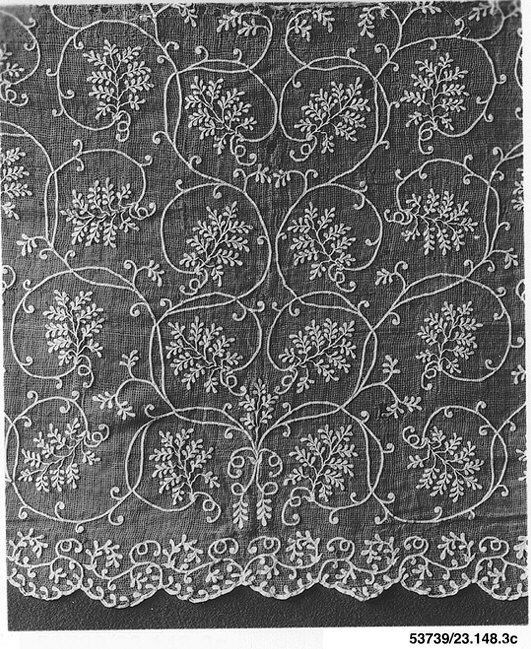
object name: sleeve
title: Bodice sleeve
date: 1801-1850